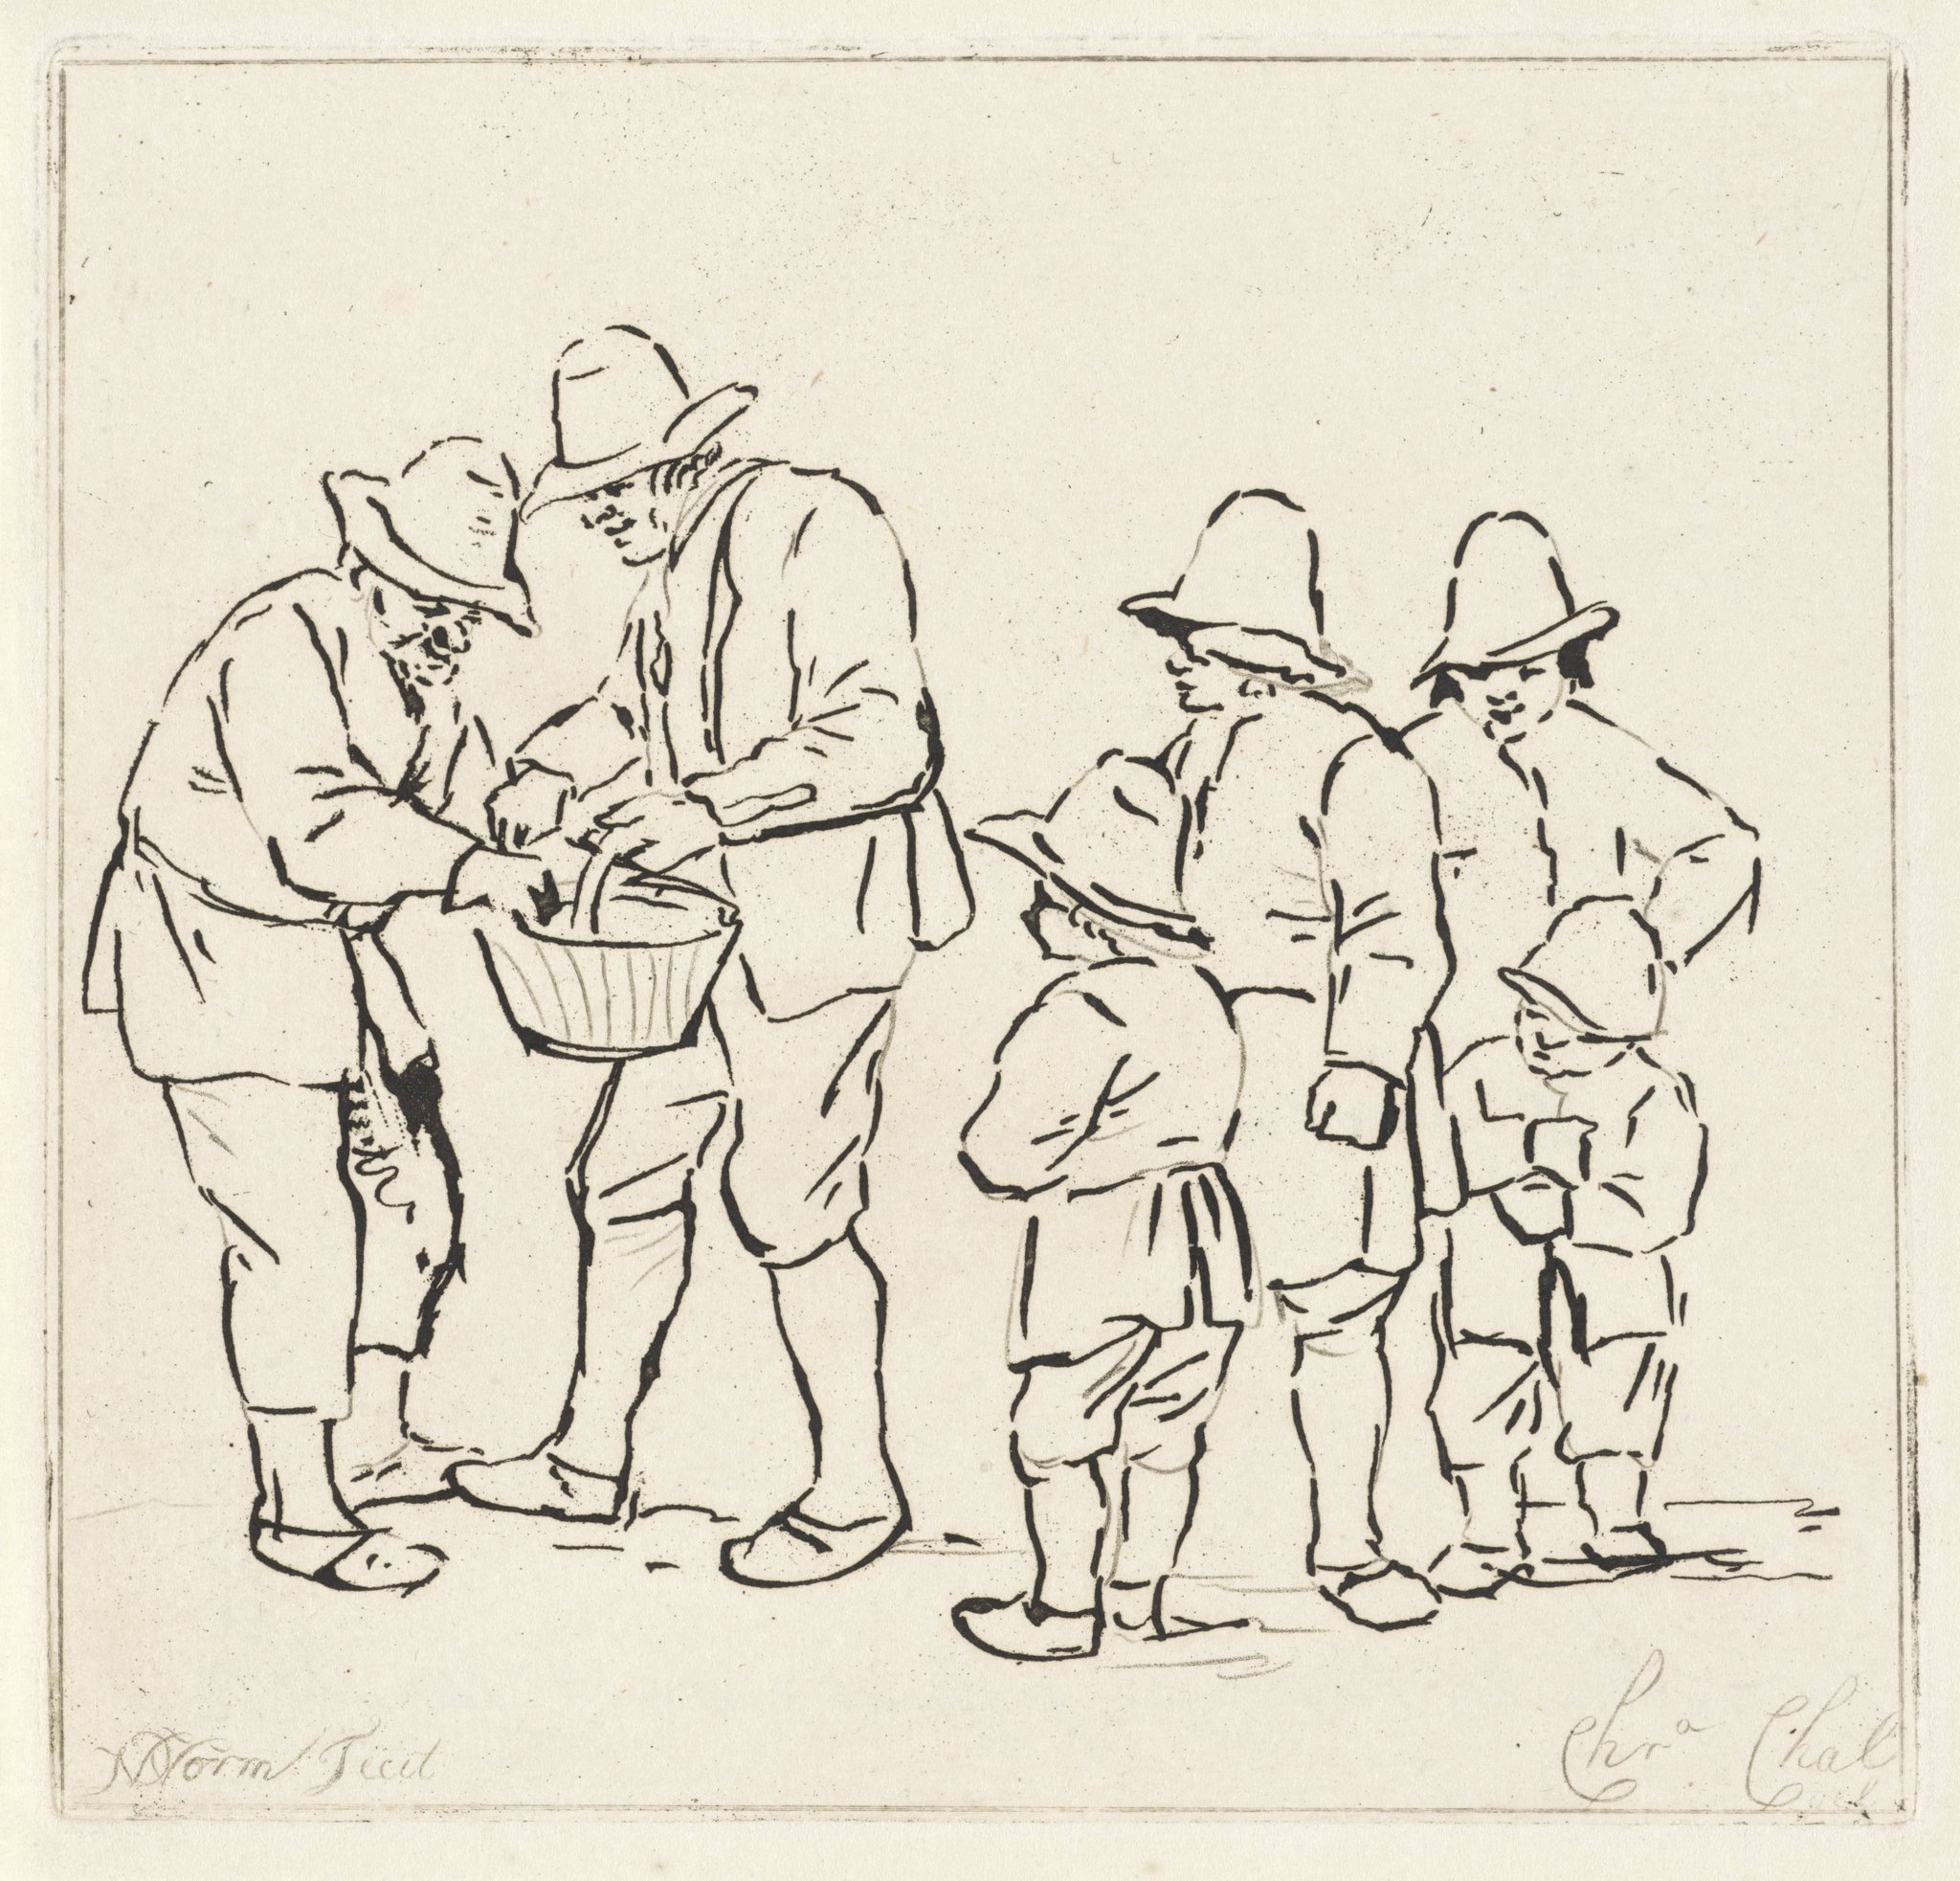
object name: print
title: Groep mannen en jongens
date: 1772-1828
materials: paper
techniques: etching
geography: leiden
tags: container made of plant material other than wood: basket, father and child(ren), man and child(ren) (family group)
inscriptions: dedication: ‘Aan de heer van Vlaardingen geoffereert door de hr. Van Buren’, collector's mark: Lugt 240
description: Twee mannen houden een mand vast en drie jongens kijken toe.